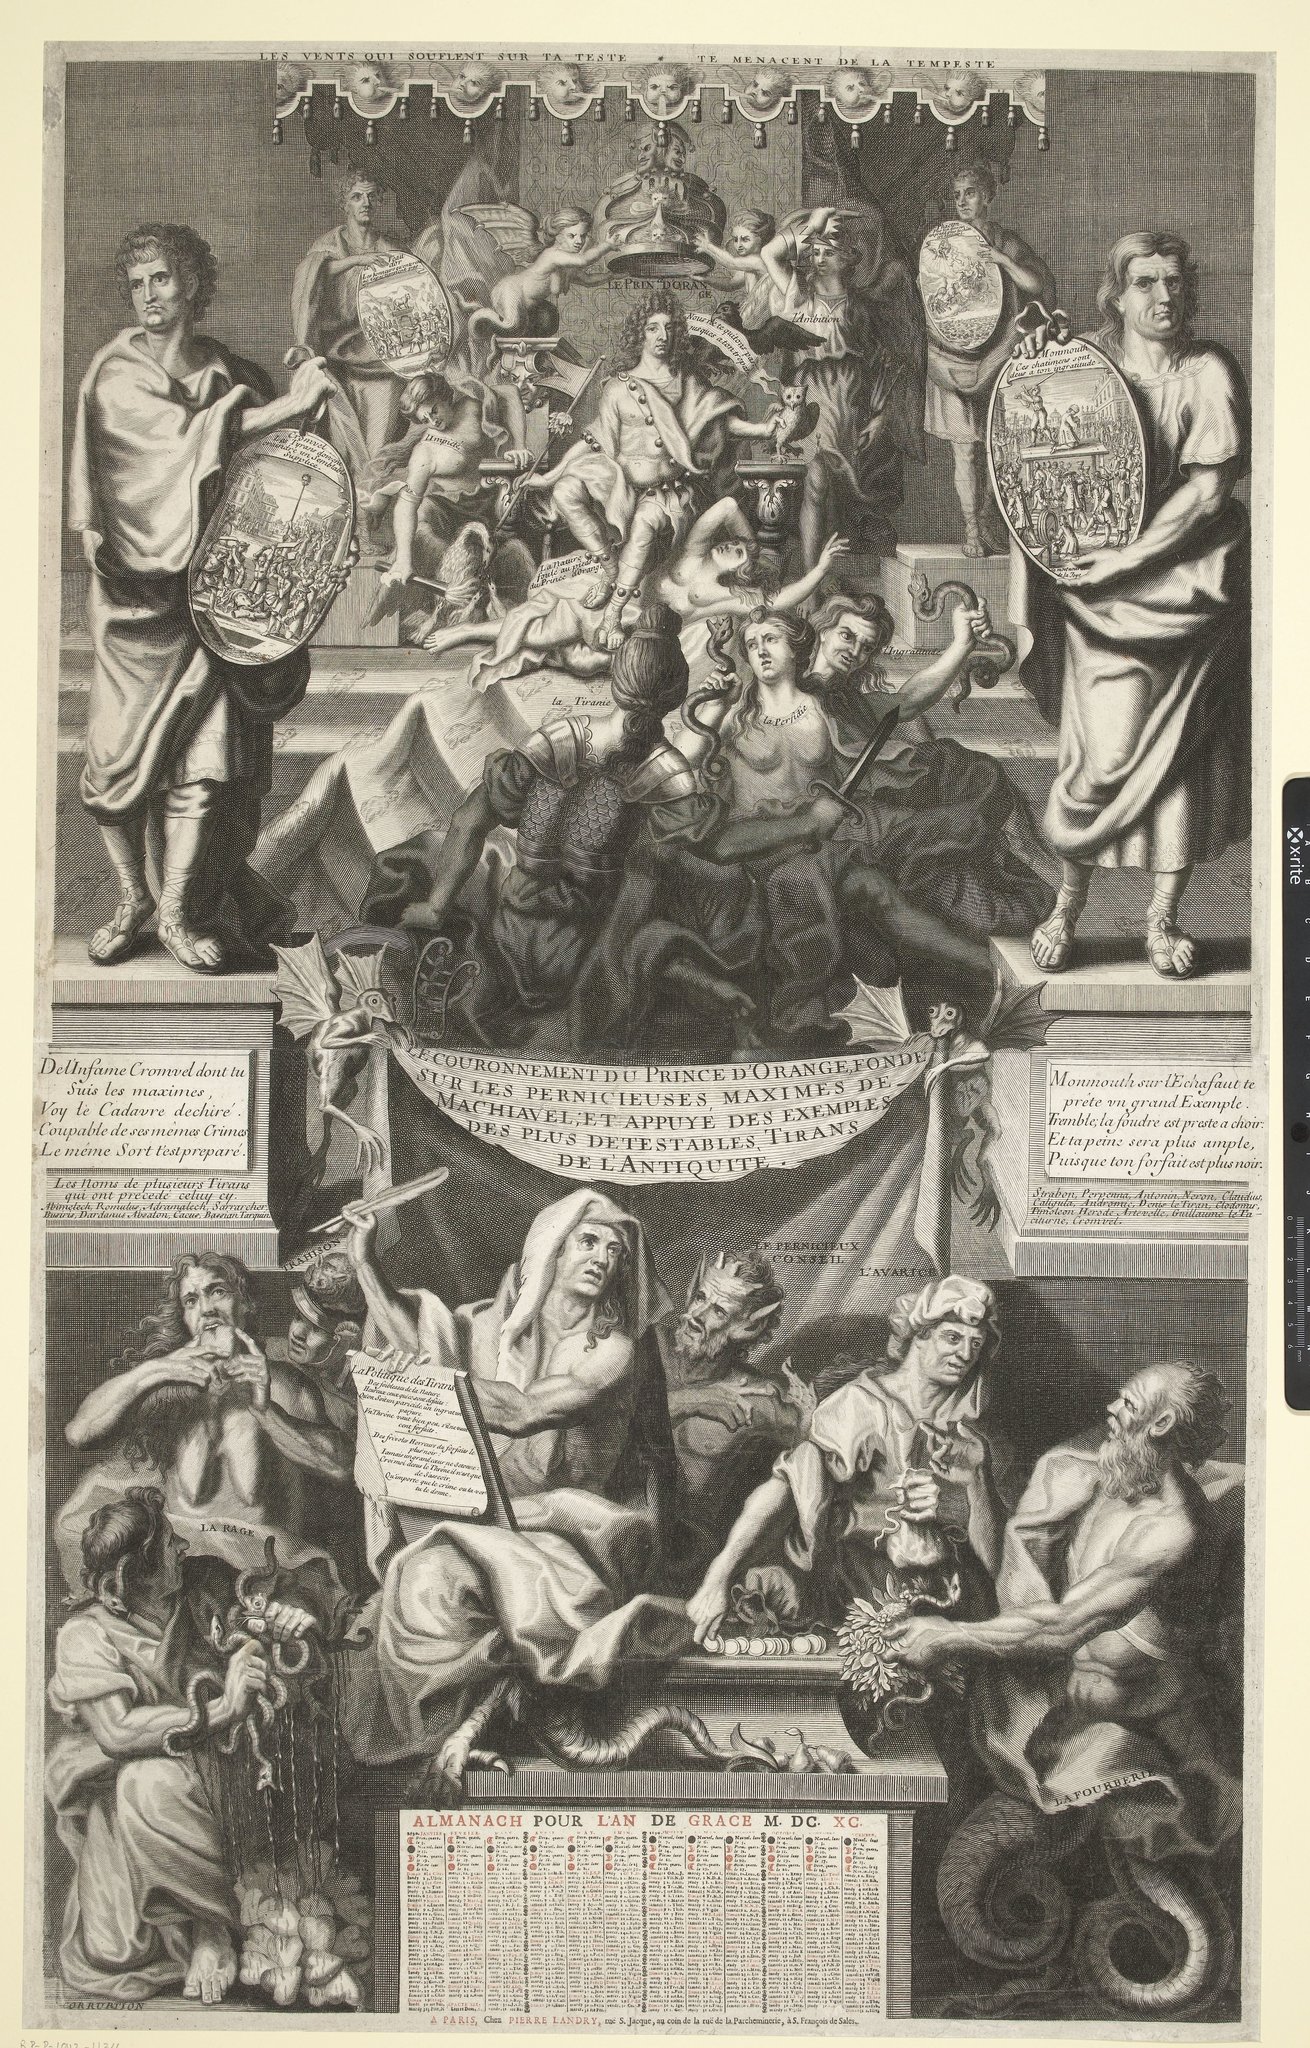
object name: print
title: French satirical print of the coronation of William III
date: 1689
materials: paper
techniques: engraving, etching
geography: paris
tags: the hague, william iii (prince of orange and king of england, scotland, and ireland), tyrant, dictator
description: In France there was fierce opposition to the 1689 coronation of Stadtholder William III as king of England, Scotland and Ireland. Here, the event is presented as unnatural. This explains the prince’s small stature. The frogs scattered throughout the picture refer to a French epithet for the Dutch. Many French satirical prints took the form of almanac prints like this one, with an image and a printed calendar underneath.